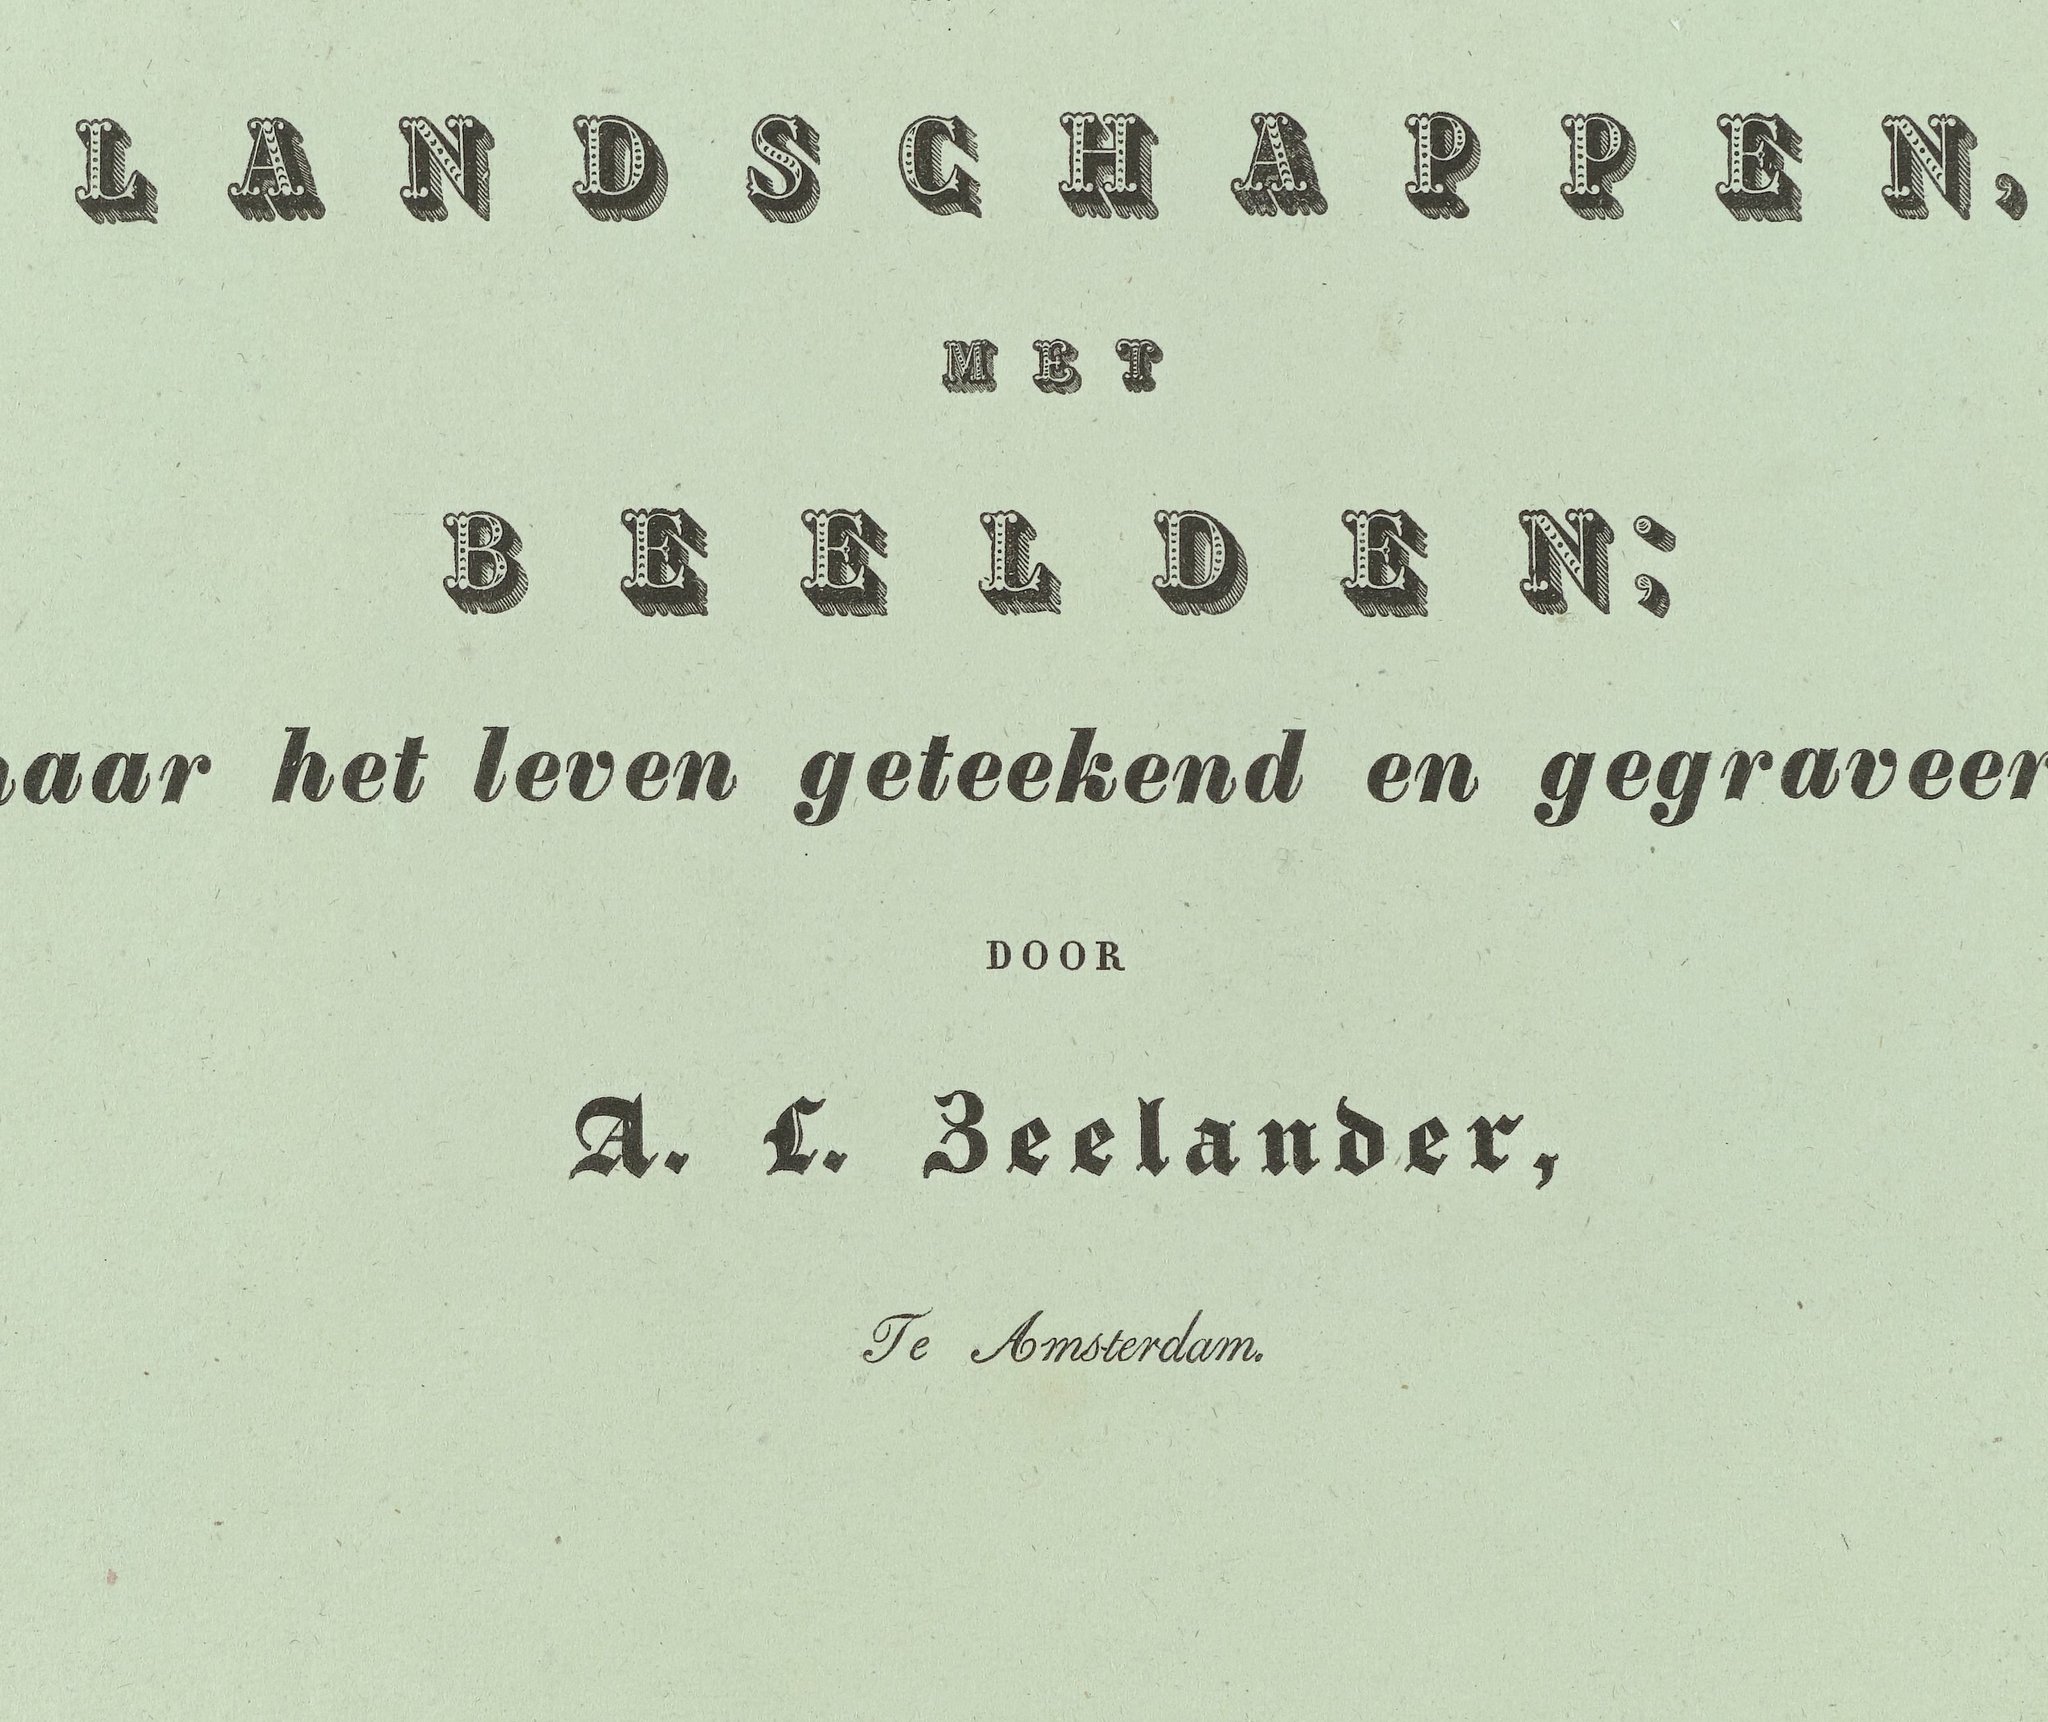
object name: wrapper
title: Zes landschappen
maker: abraham lion zeelander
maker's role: draughtsman, print maker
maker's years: 1789-1856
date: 1799-1856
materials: paper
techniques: letterpress printing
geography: amsterdam